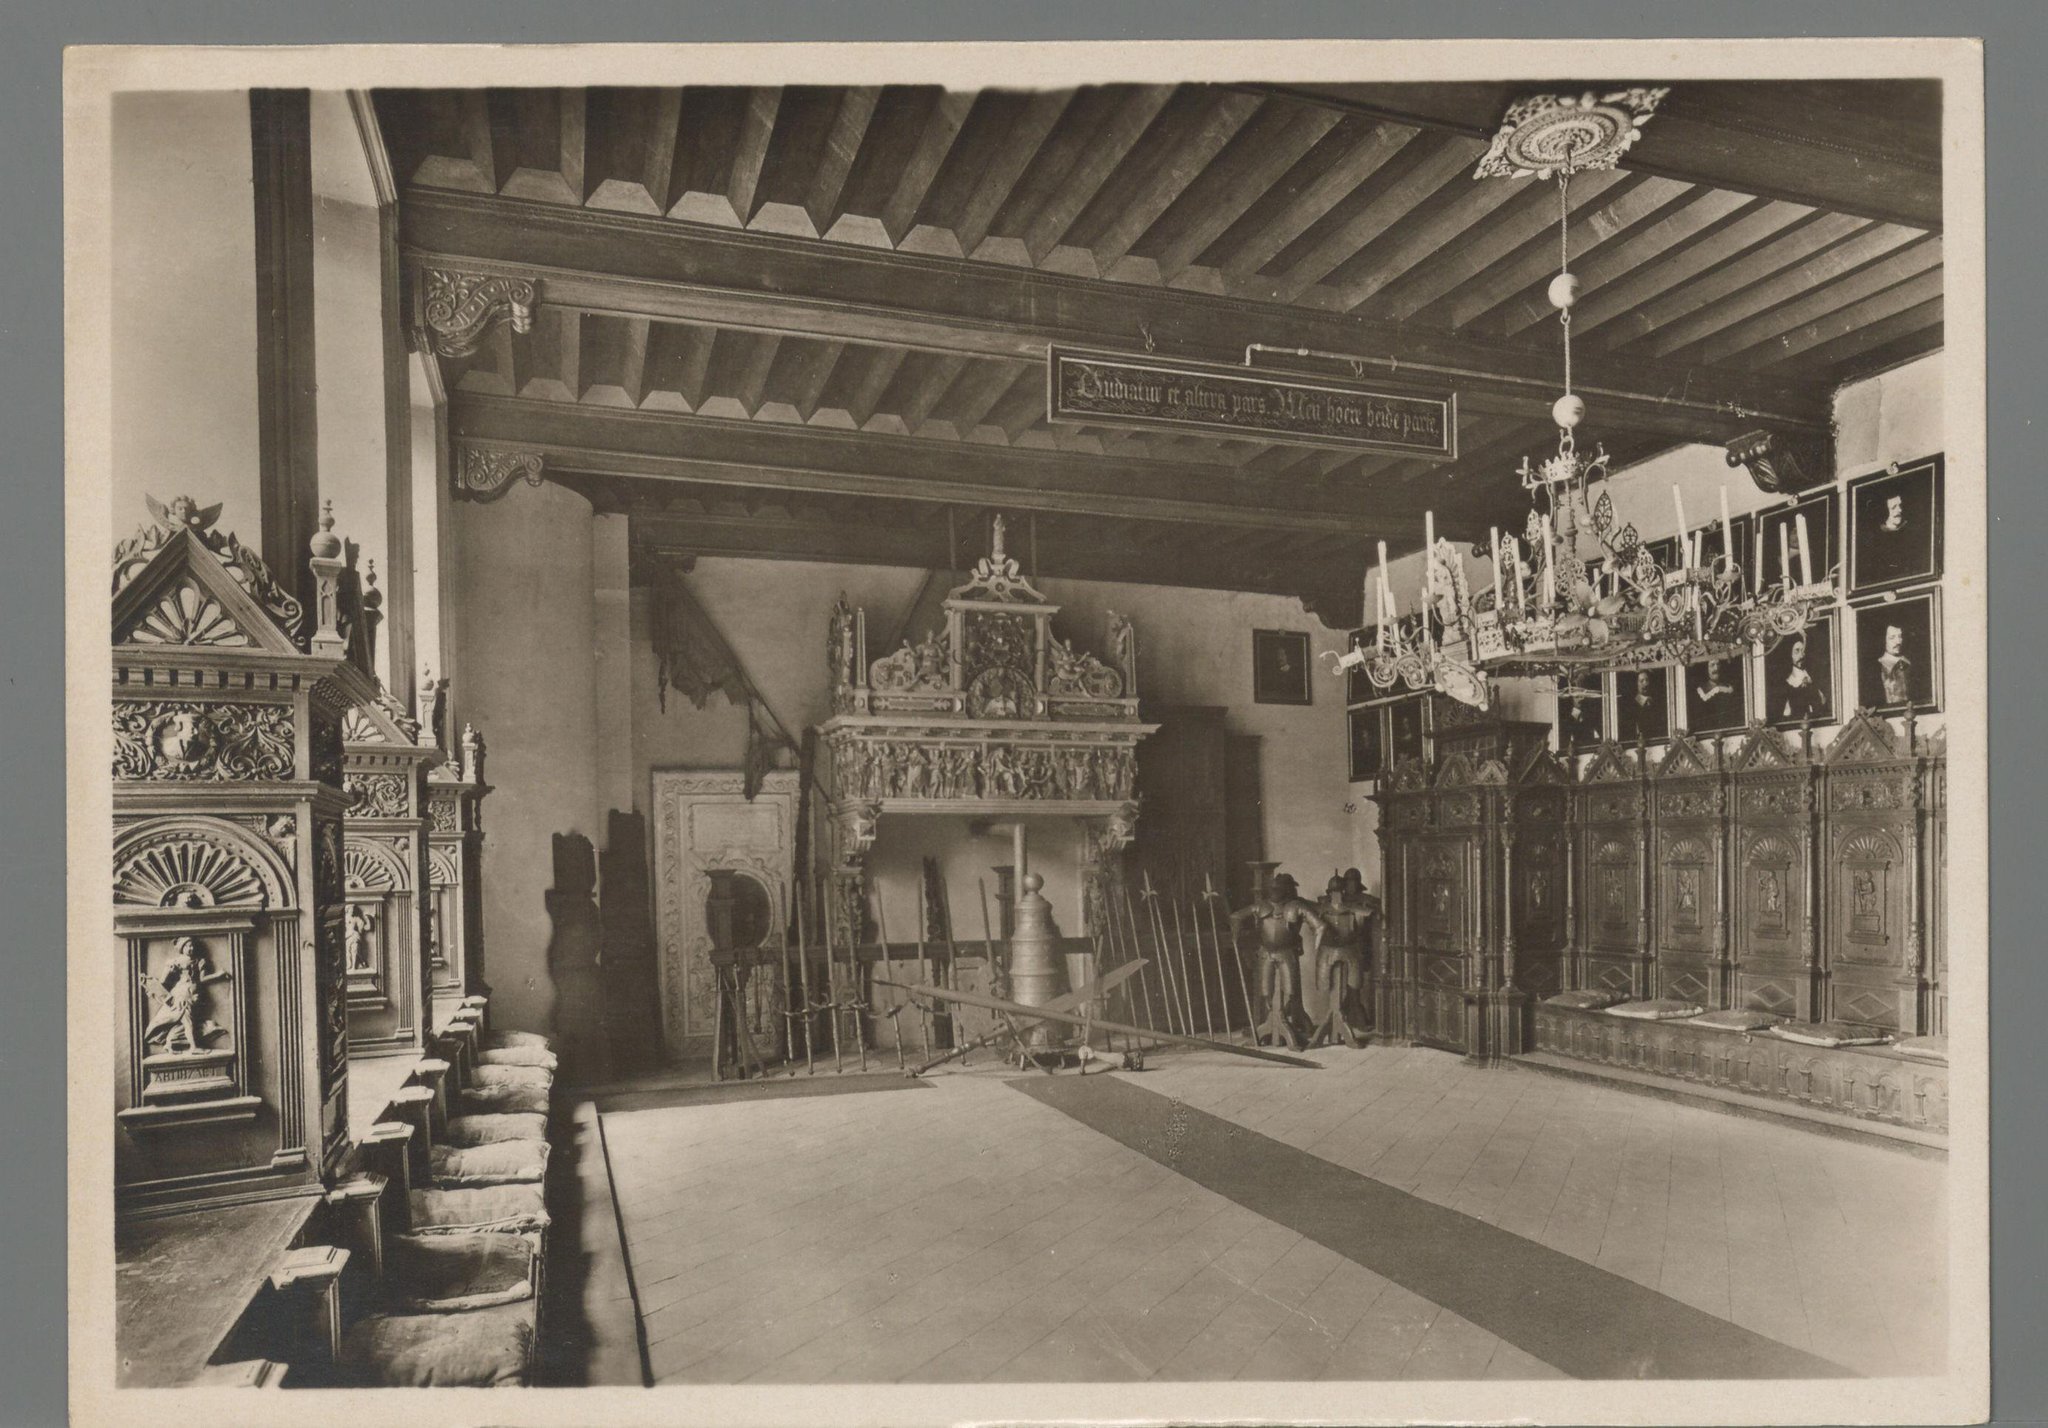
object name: photograph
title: Münster i. W. Rathaus. Friedenssaal mit Wandvertäfelung von 1577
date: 1905-1940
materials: photographic support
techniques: gelatin silver print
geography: berlin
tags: townhall, interior of the house